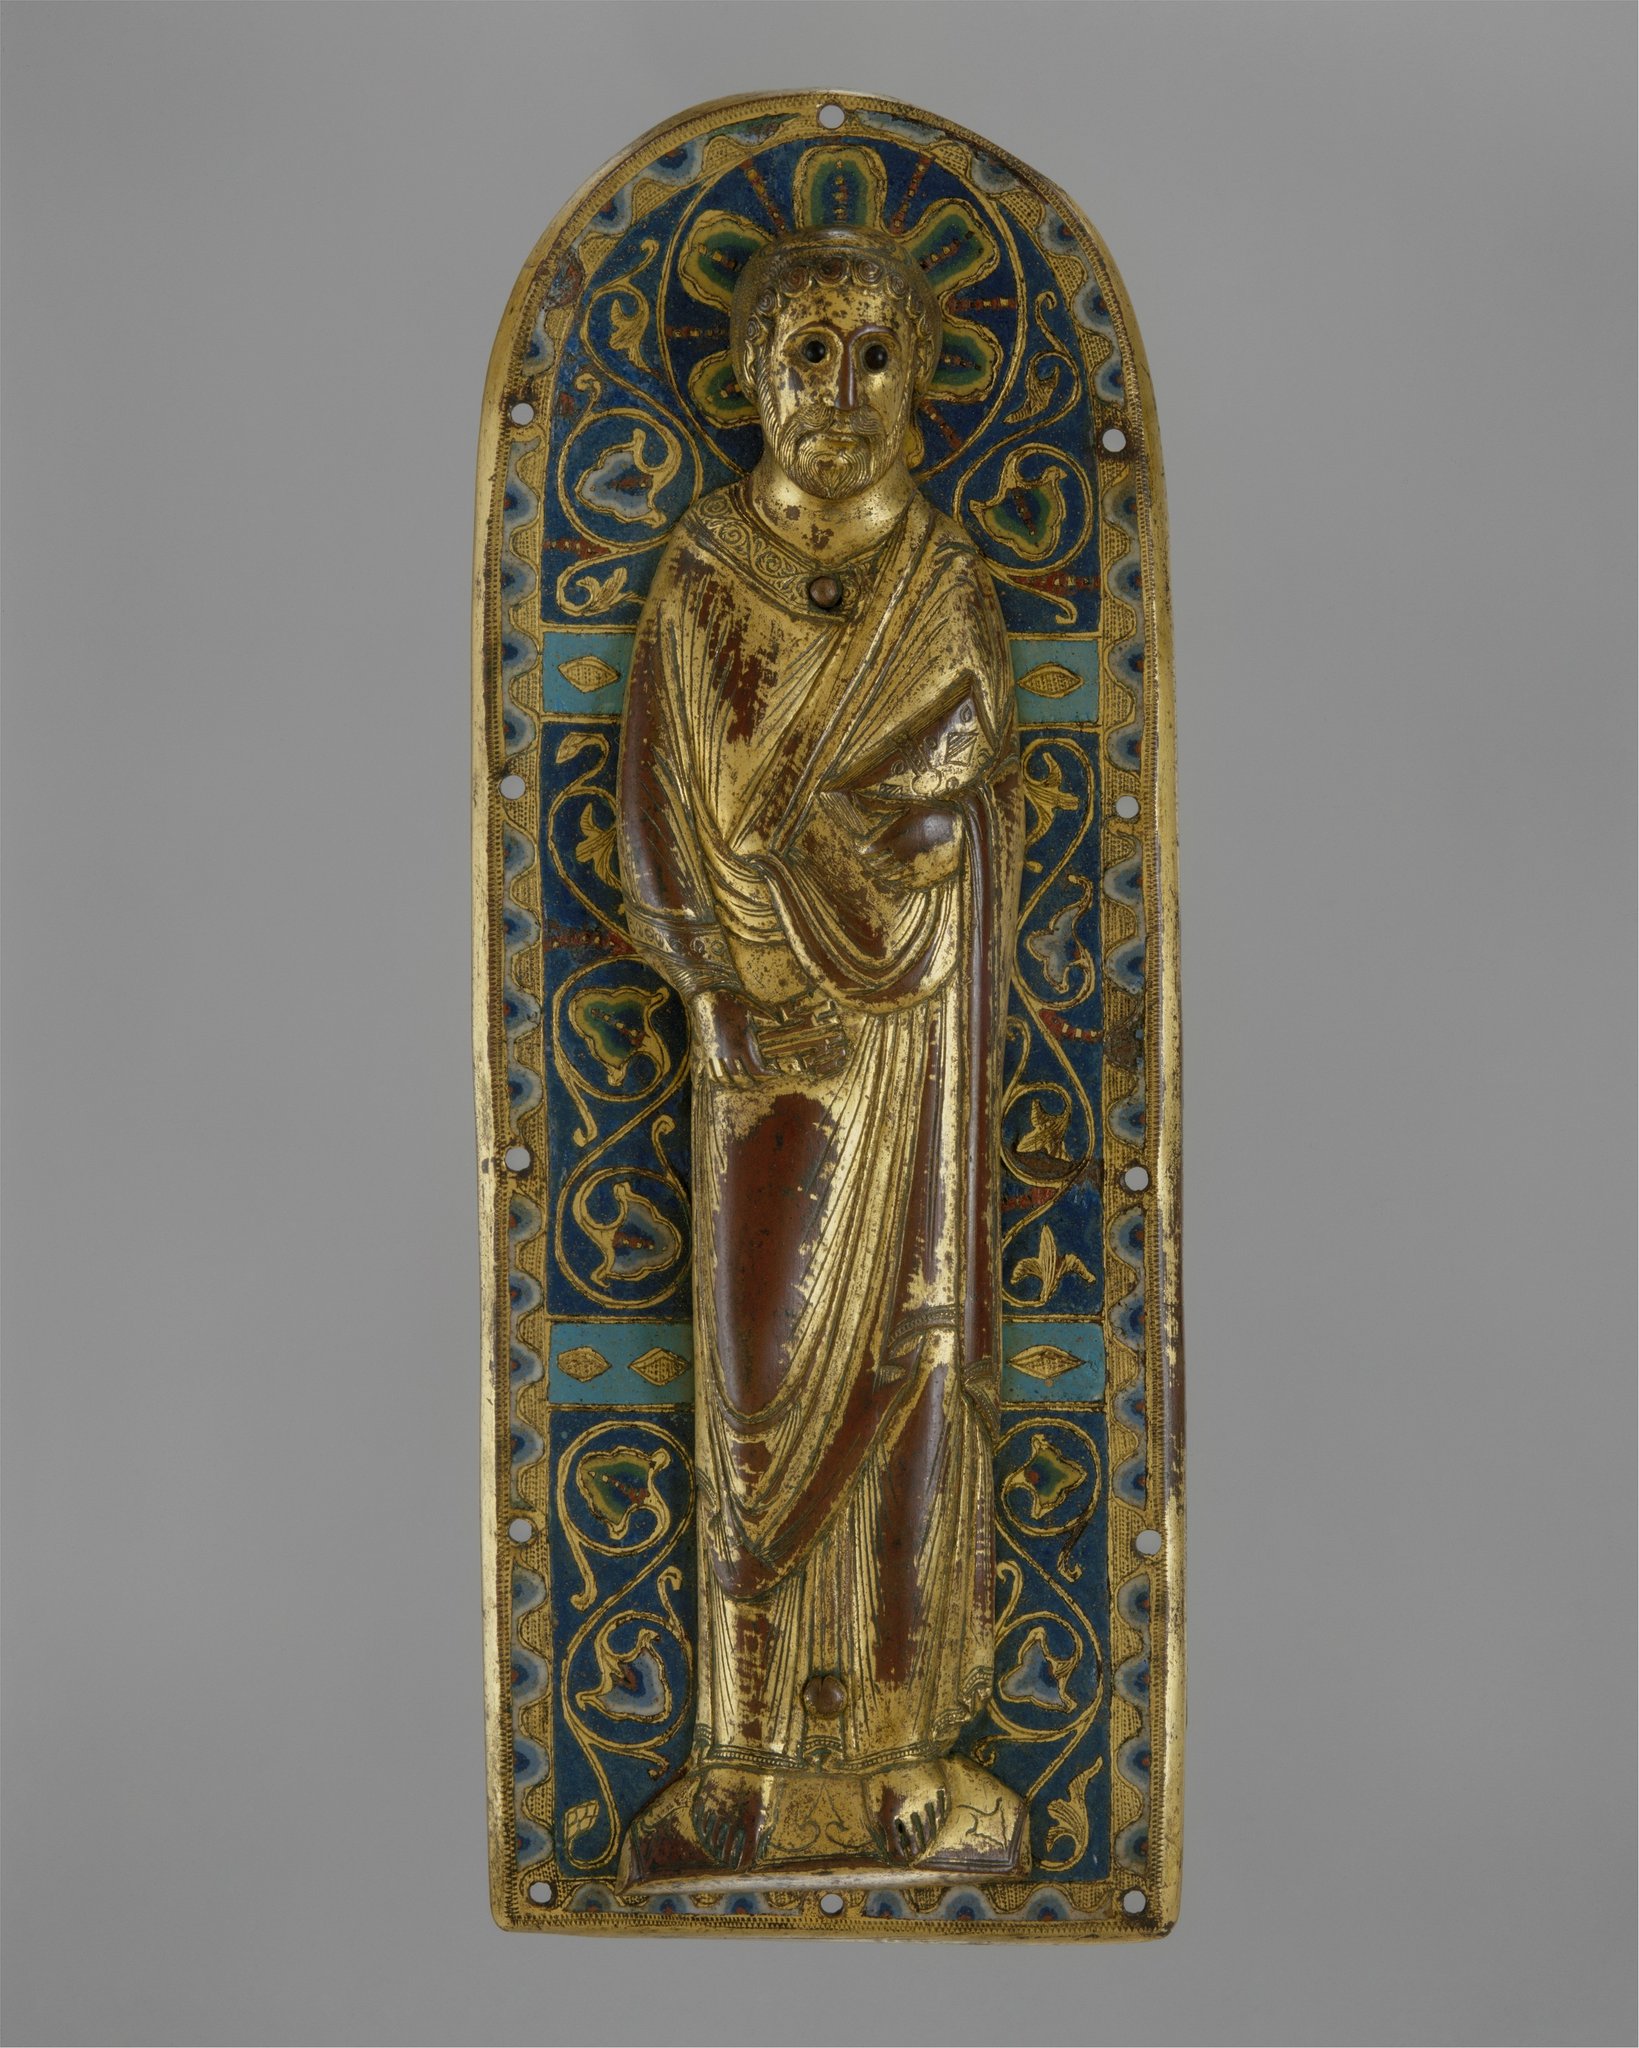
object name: plaque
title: Plaque with Saint Peter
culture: french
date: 1185-1200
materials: copper, enamel, gilt, glass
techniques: enamel, chasing, engraving, repoussé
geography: france